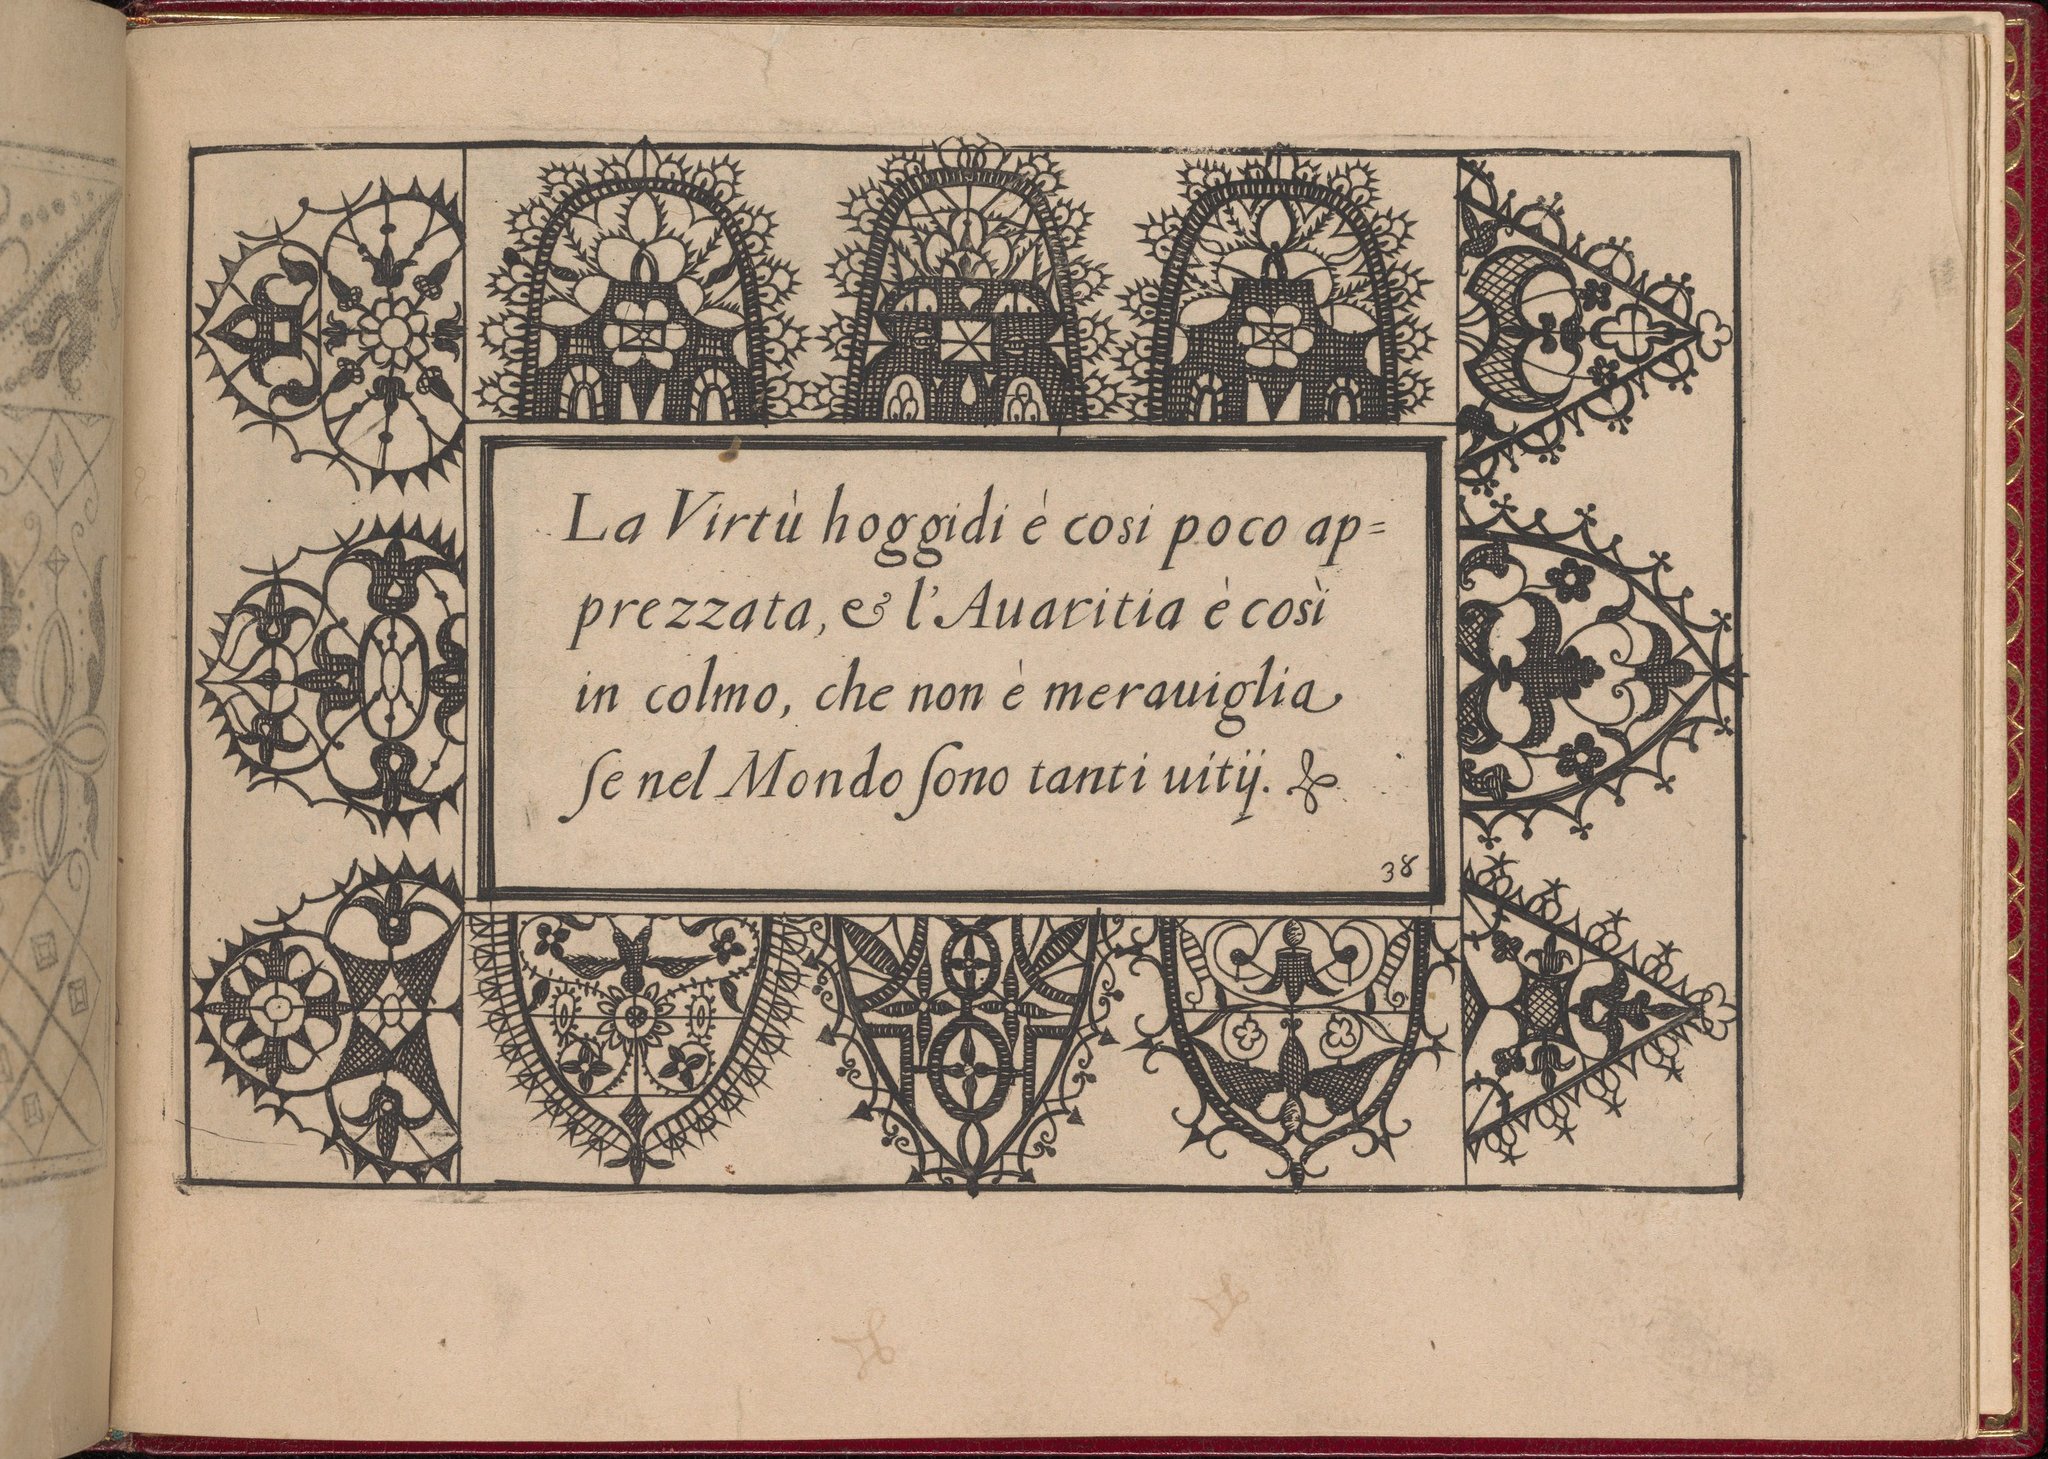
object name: book print ornament architecture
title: Ghirlanda: Di sei vaghi fiori scielti da piu famosi Giardini d'Italia, page 46 (recto)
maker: pietro paulo tozzi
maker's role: designer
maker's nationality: italian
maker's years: 1593-1628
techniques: drawing, etching